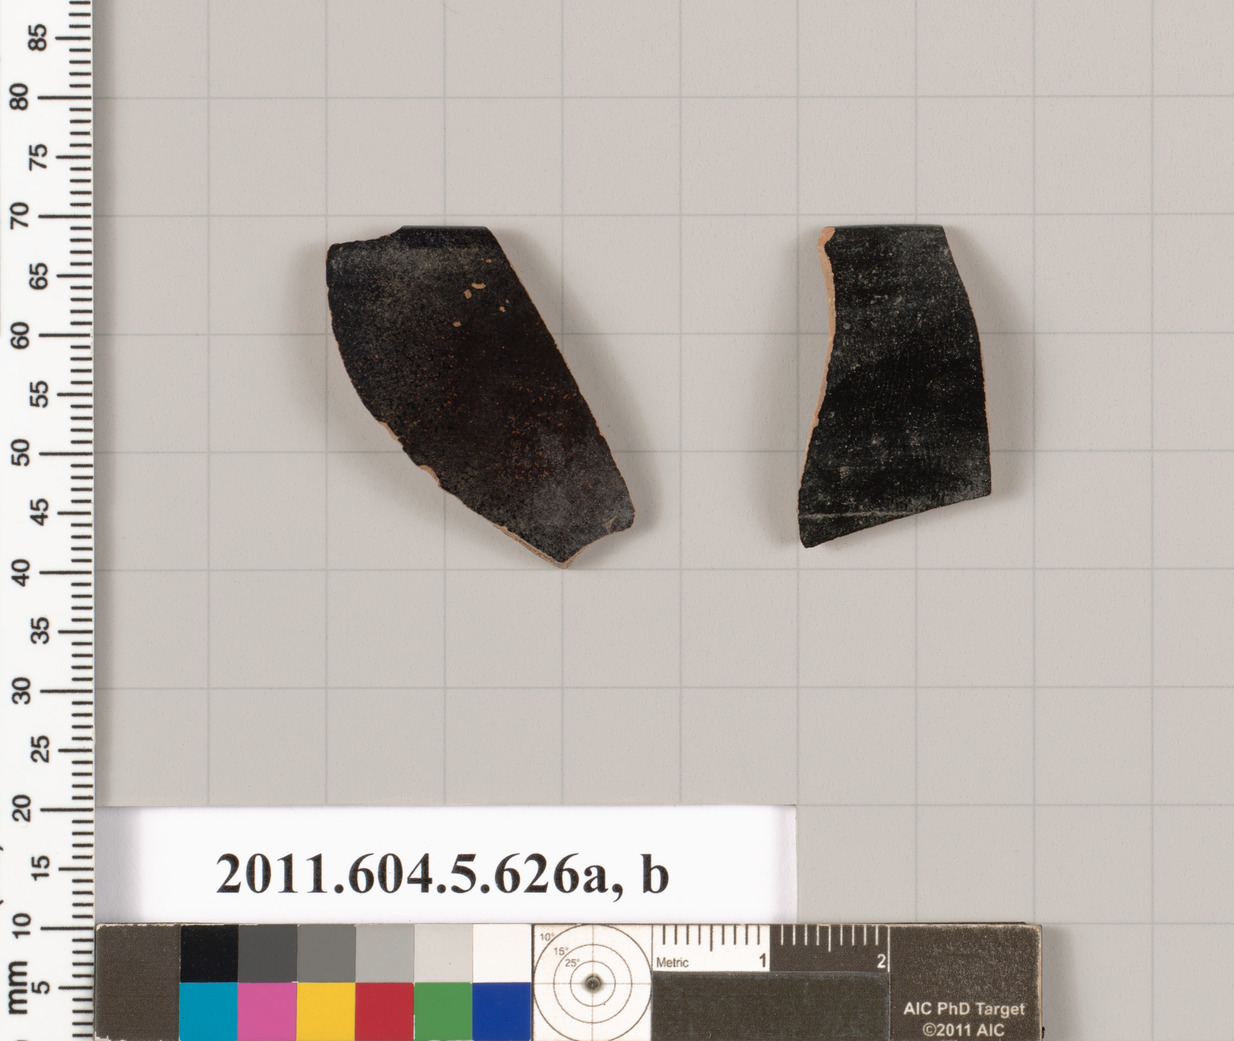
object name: kylix fragment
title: Terracotta rim fragments of kylikes (drinking cups)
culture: greek, attic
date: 600-401 BCE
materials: terracotta